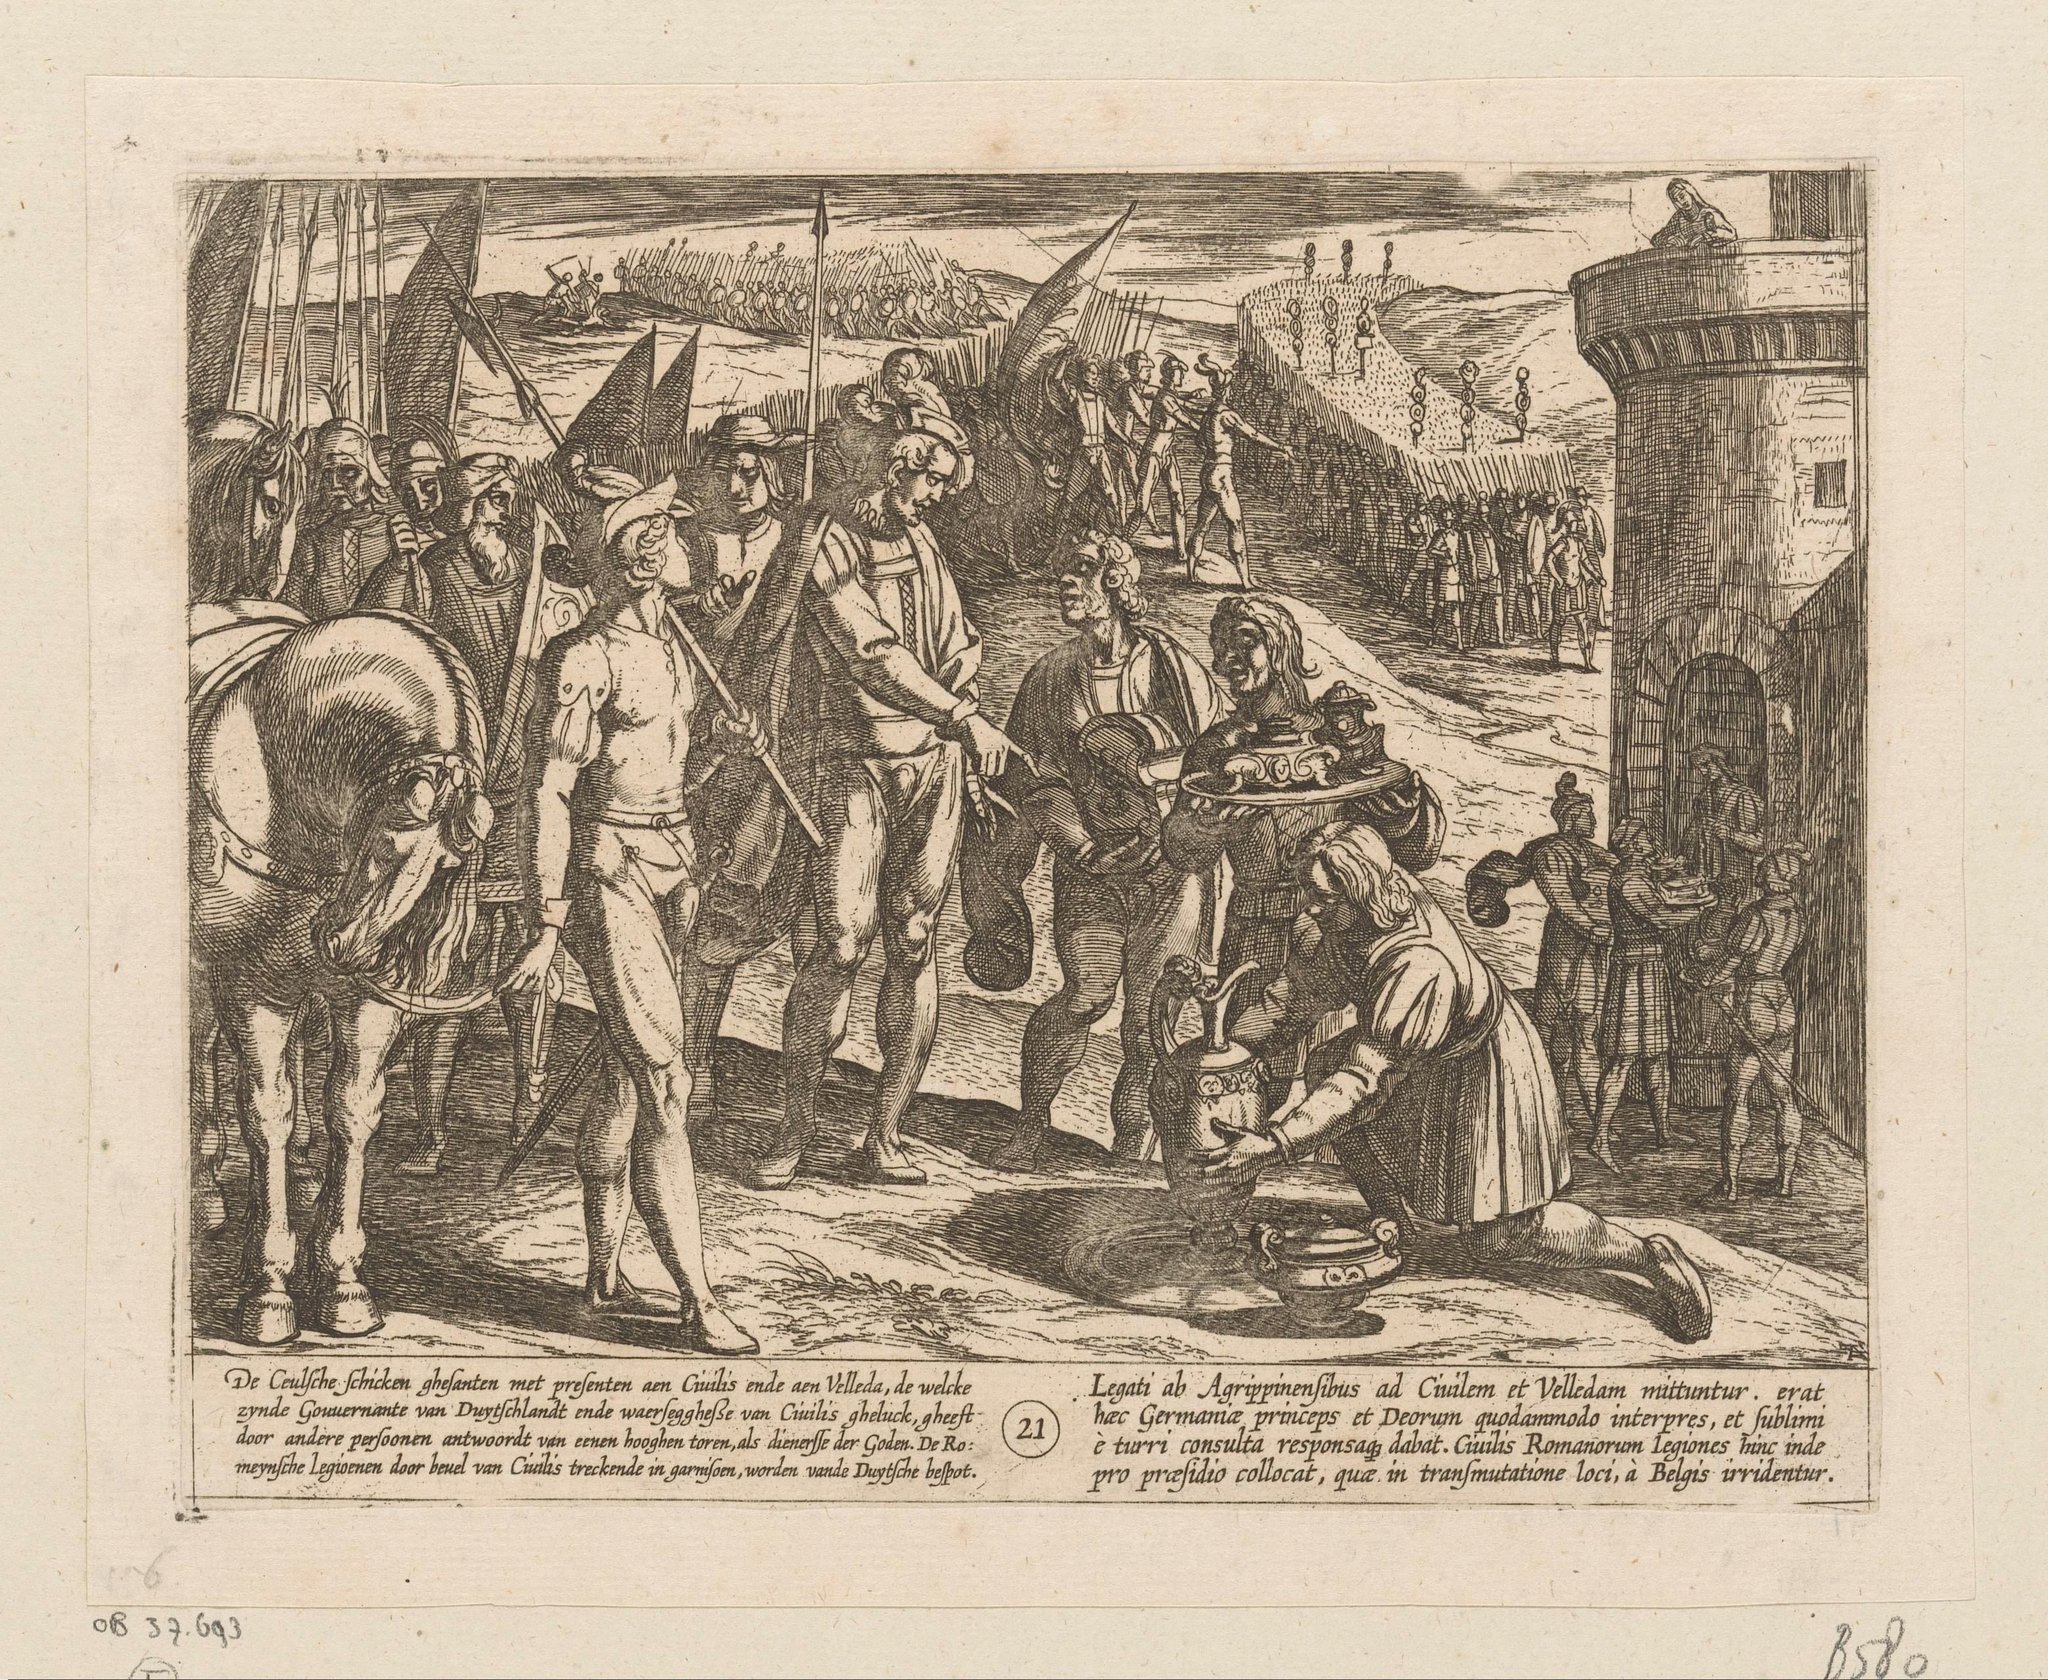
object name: print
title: Gezanten uit Keulen brengen Civilis geschenken, 69-70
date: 1612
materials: paper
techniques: etching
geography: italy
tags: extinct, 'historical' peoples (with name), netherlands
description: Gezanten uit Keulen brengen Civilis geschenken. Prent nummer 21 in de serie prenten over de Bataafse Opstand: Batavorum cum Romanis bellum / à Corn. Tacito lib. IV & V. : Hist. olim descriptum, figuris nunc aeneis expressum, auctore Othone Vaenio Lugdunobatava = De Batavische oft oude Hollandtsche oorloghe teghen de Romeynen. Otto Vaenius, Antwerpen 1612. Onderaan twee verzen van vier regels in het Nederlands en in het Latijn. Zonder tekst op achterzijde.